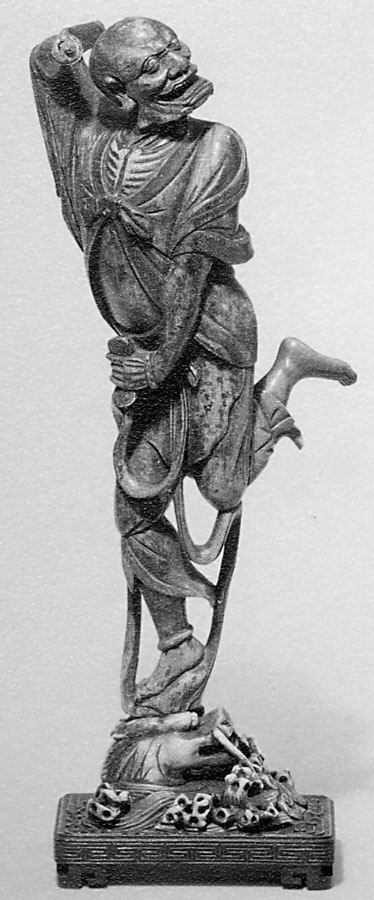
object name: statuette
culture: chinese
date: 1767-1800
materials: ivory, wood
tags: men